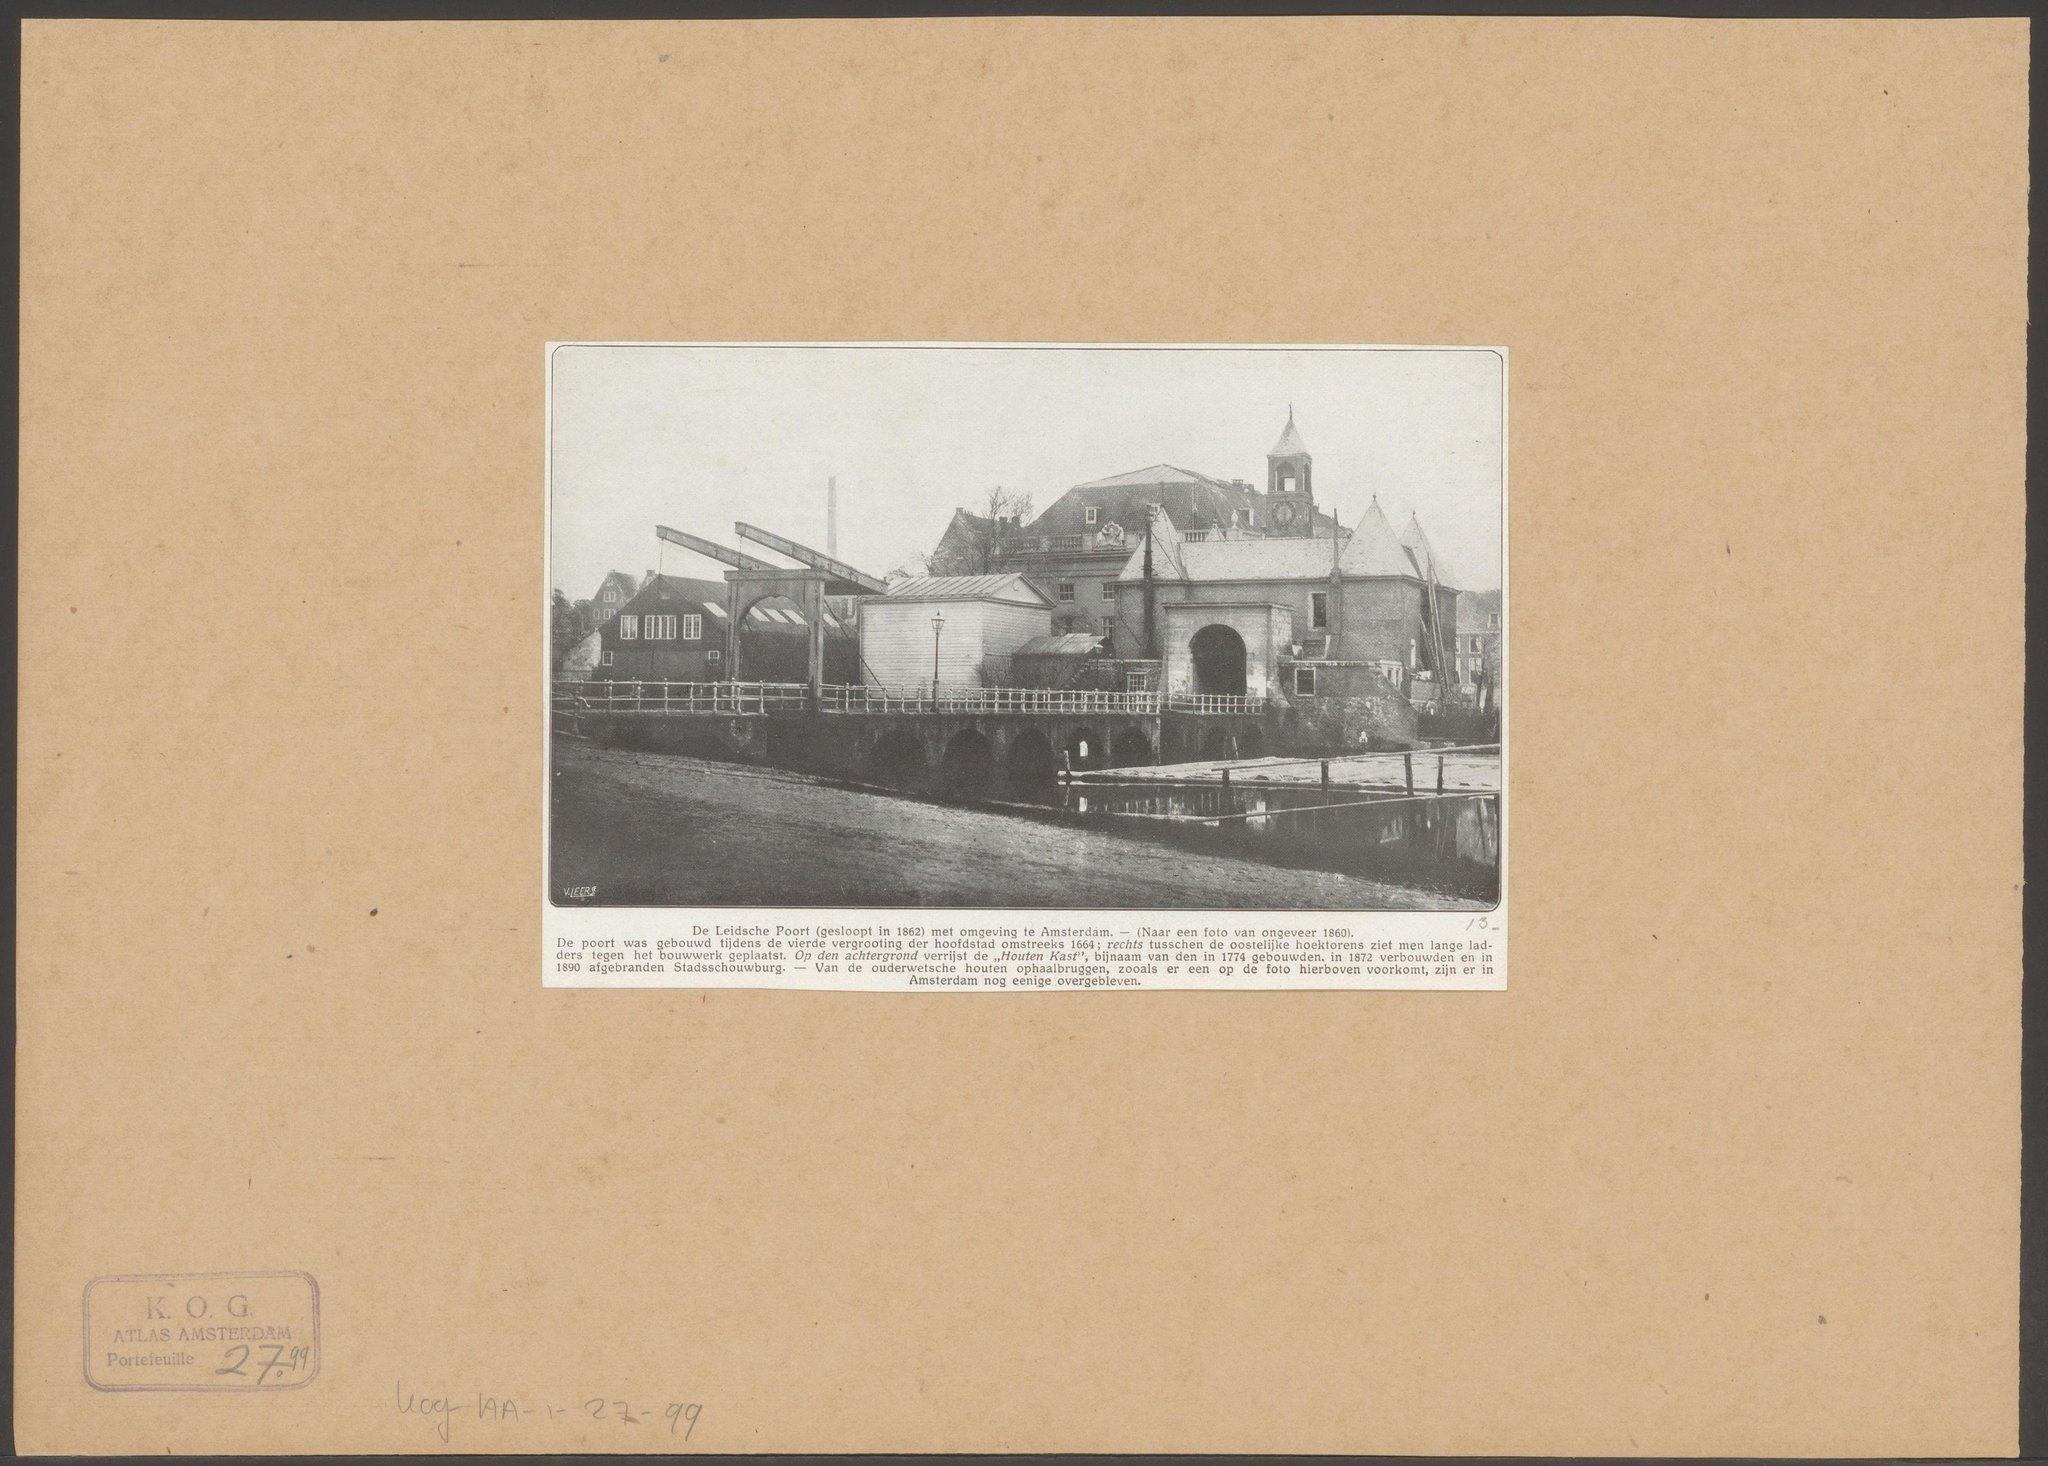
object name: photomechanical print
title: Gezicht op de Leidsepoort te Amsterdam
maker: Anonymous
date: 1870-1966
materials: paper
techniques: letterpress printing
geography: amsterdam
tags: city-gate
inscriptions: collector's mark: Lugt 1641b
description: Onderwerpsrubriek binnen de Atlas Amsterdam: Poorten, verzamelbladen, F. Leidsepoort.